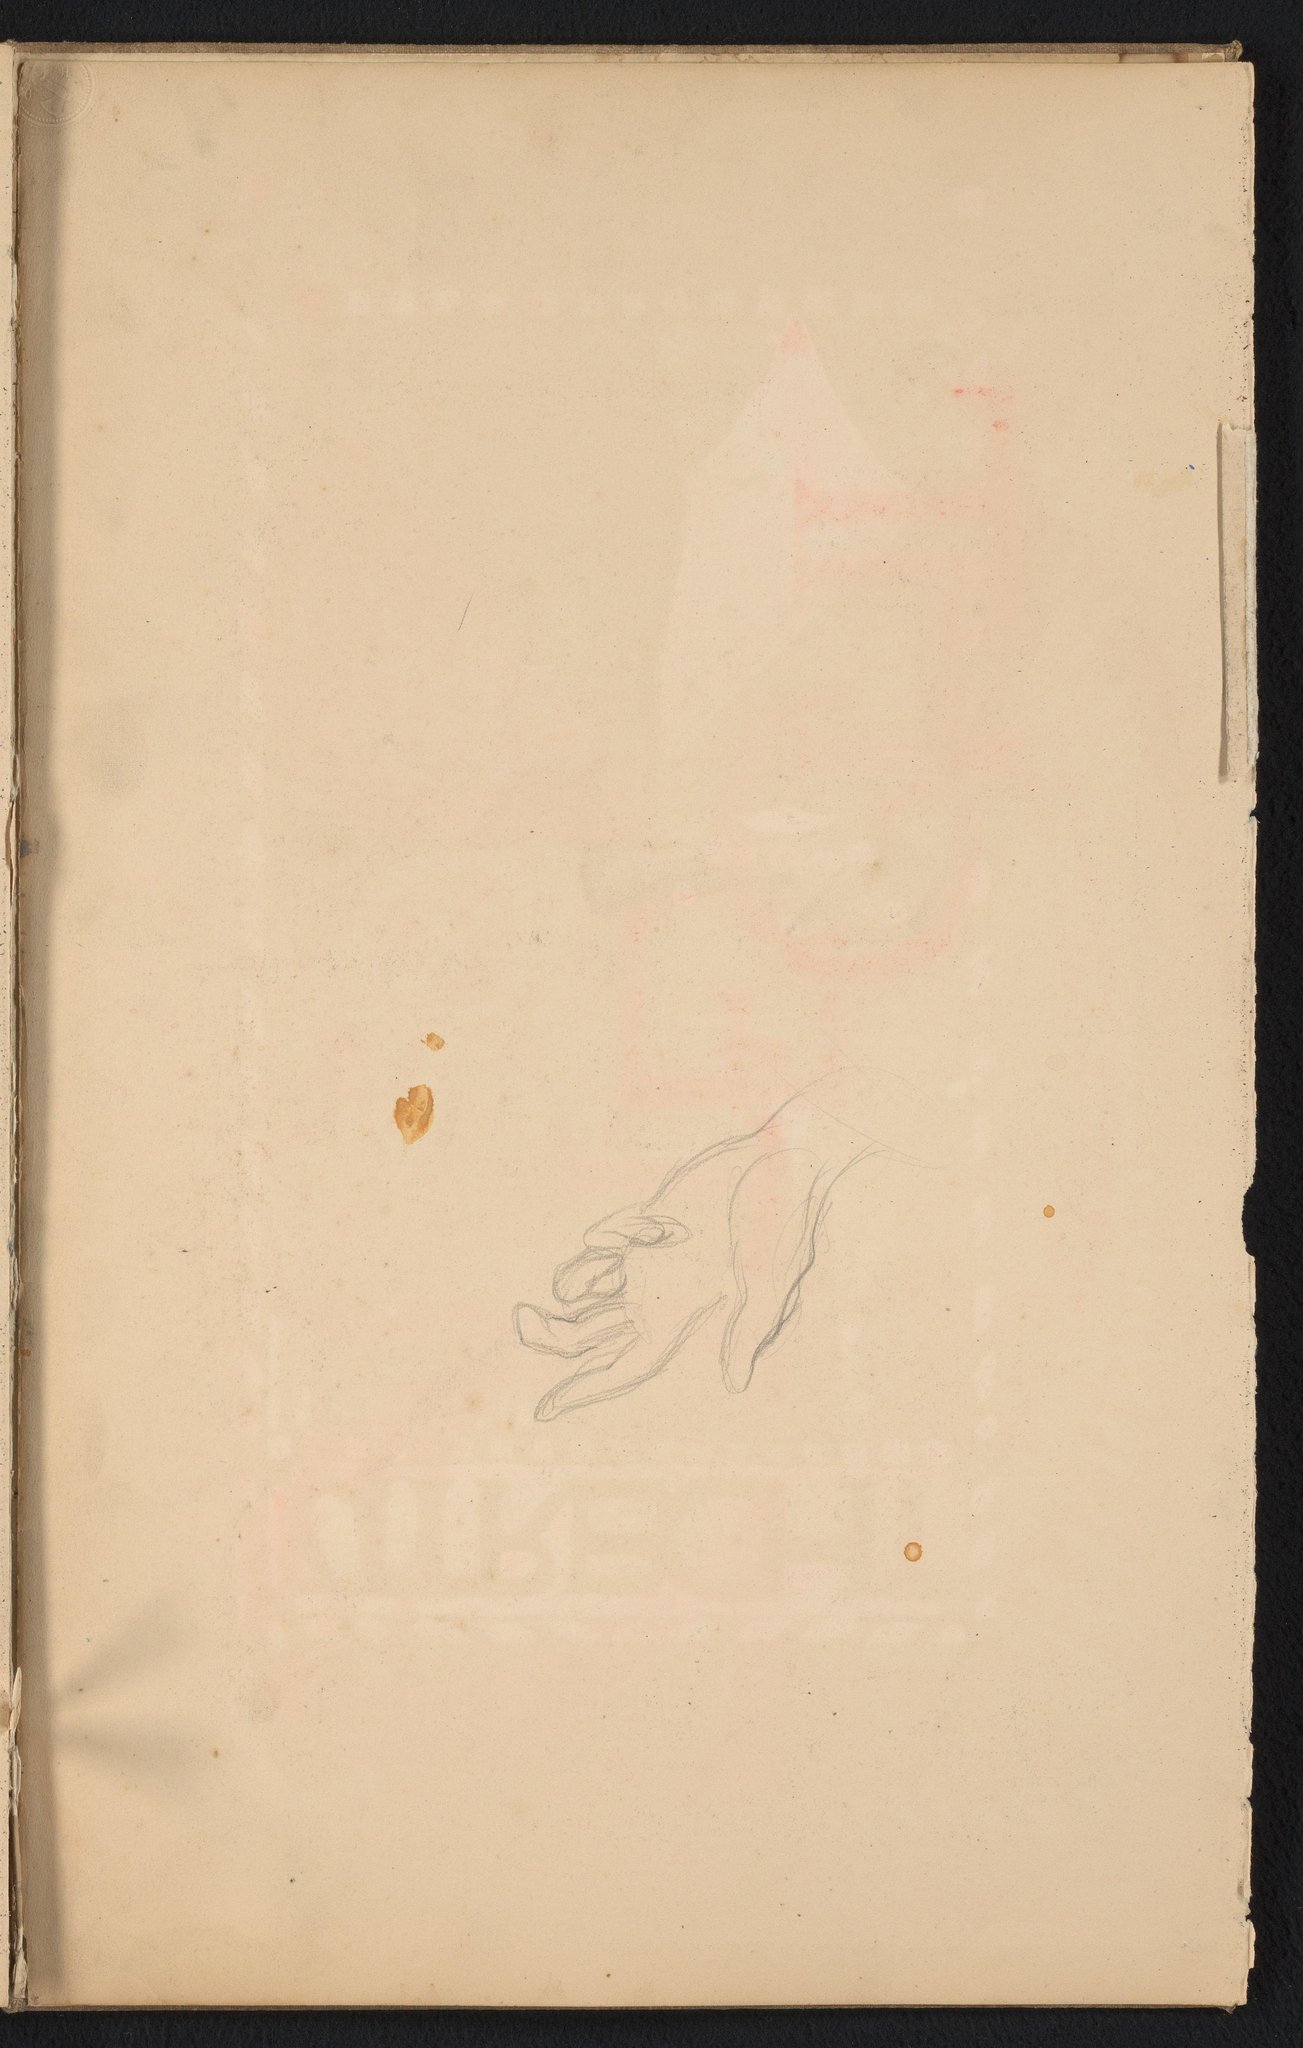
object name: sketchbook leaf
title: Hand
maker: huib luns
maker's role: draughtsman, print maker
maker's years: 1881-1942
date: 1908-1909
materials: paper, pencil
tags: hand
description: Blad 24 recto uit een schetsboek met 24 bladen.